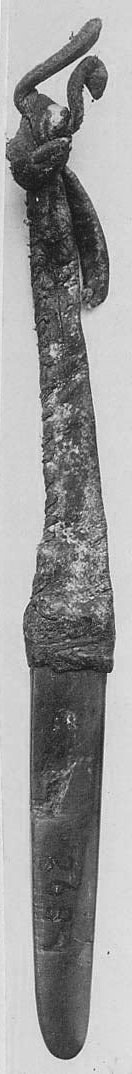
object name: knife sharpener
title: Knife-sharpener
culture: north american, alaskan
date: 1902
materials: jade